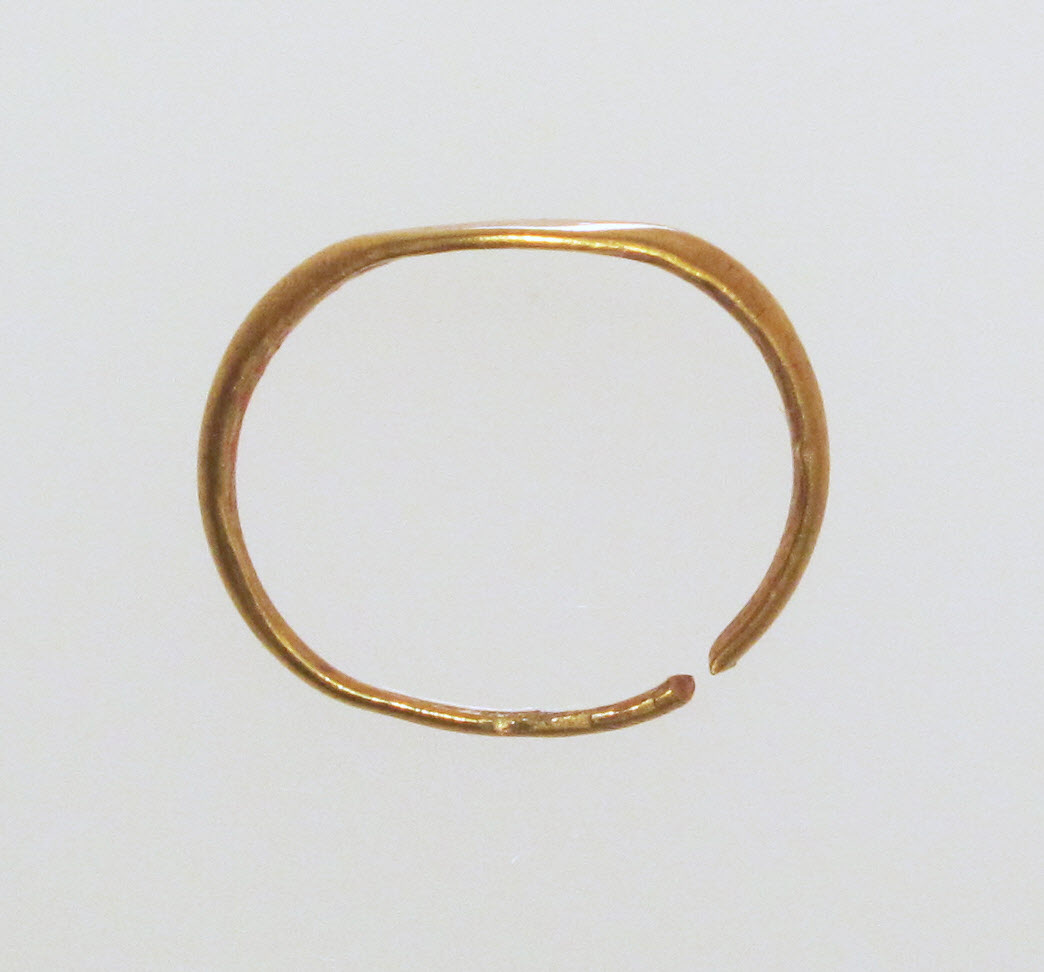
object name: ring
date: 7000 BCE-330 CE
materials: gold